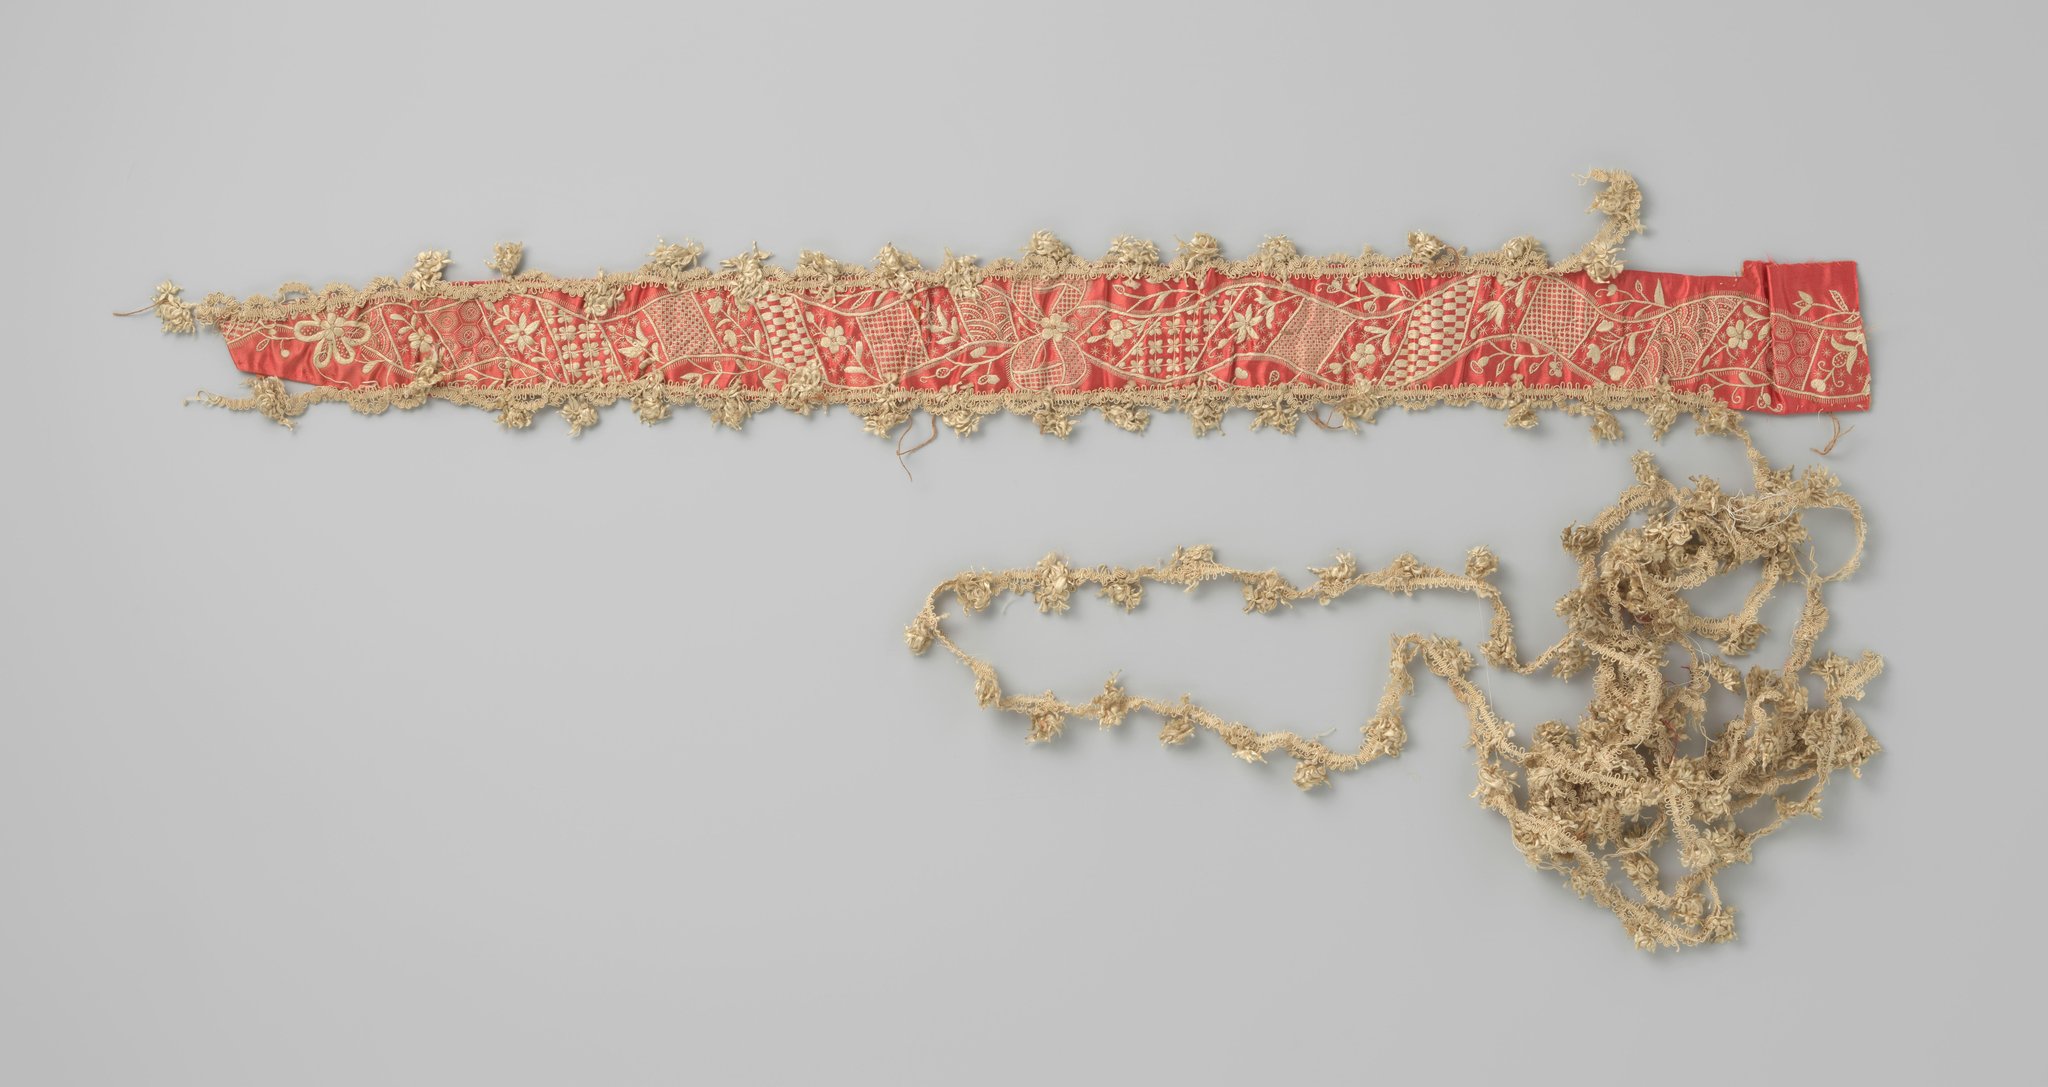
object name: strip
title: Embroidered Interior Textile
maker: Anonymous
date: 1750-1760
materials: silk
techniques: embroidered, weave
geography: france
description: Aan het passement zit los van de strook een kluwen van het passement.